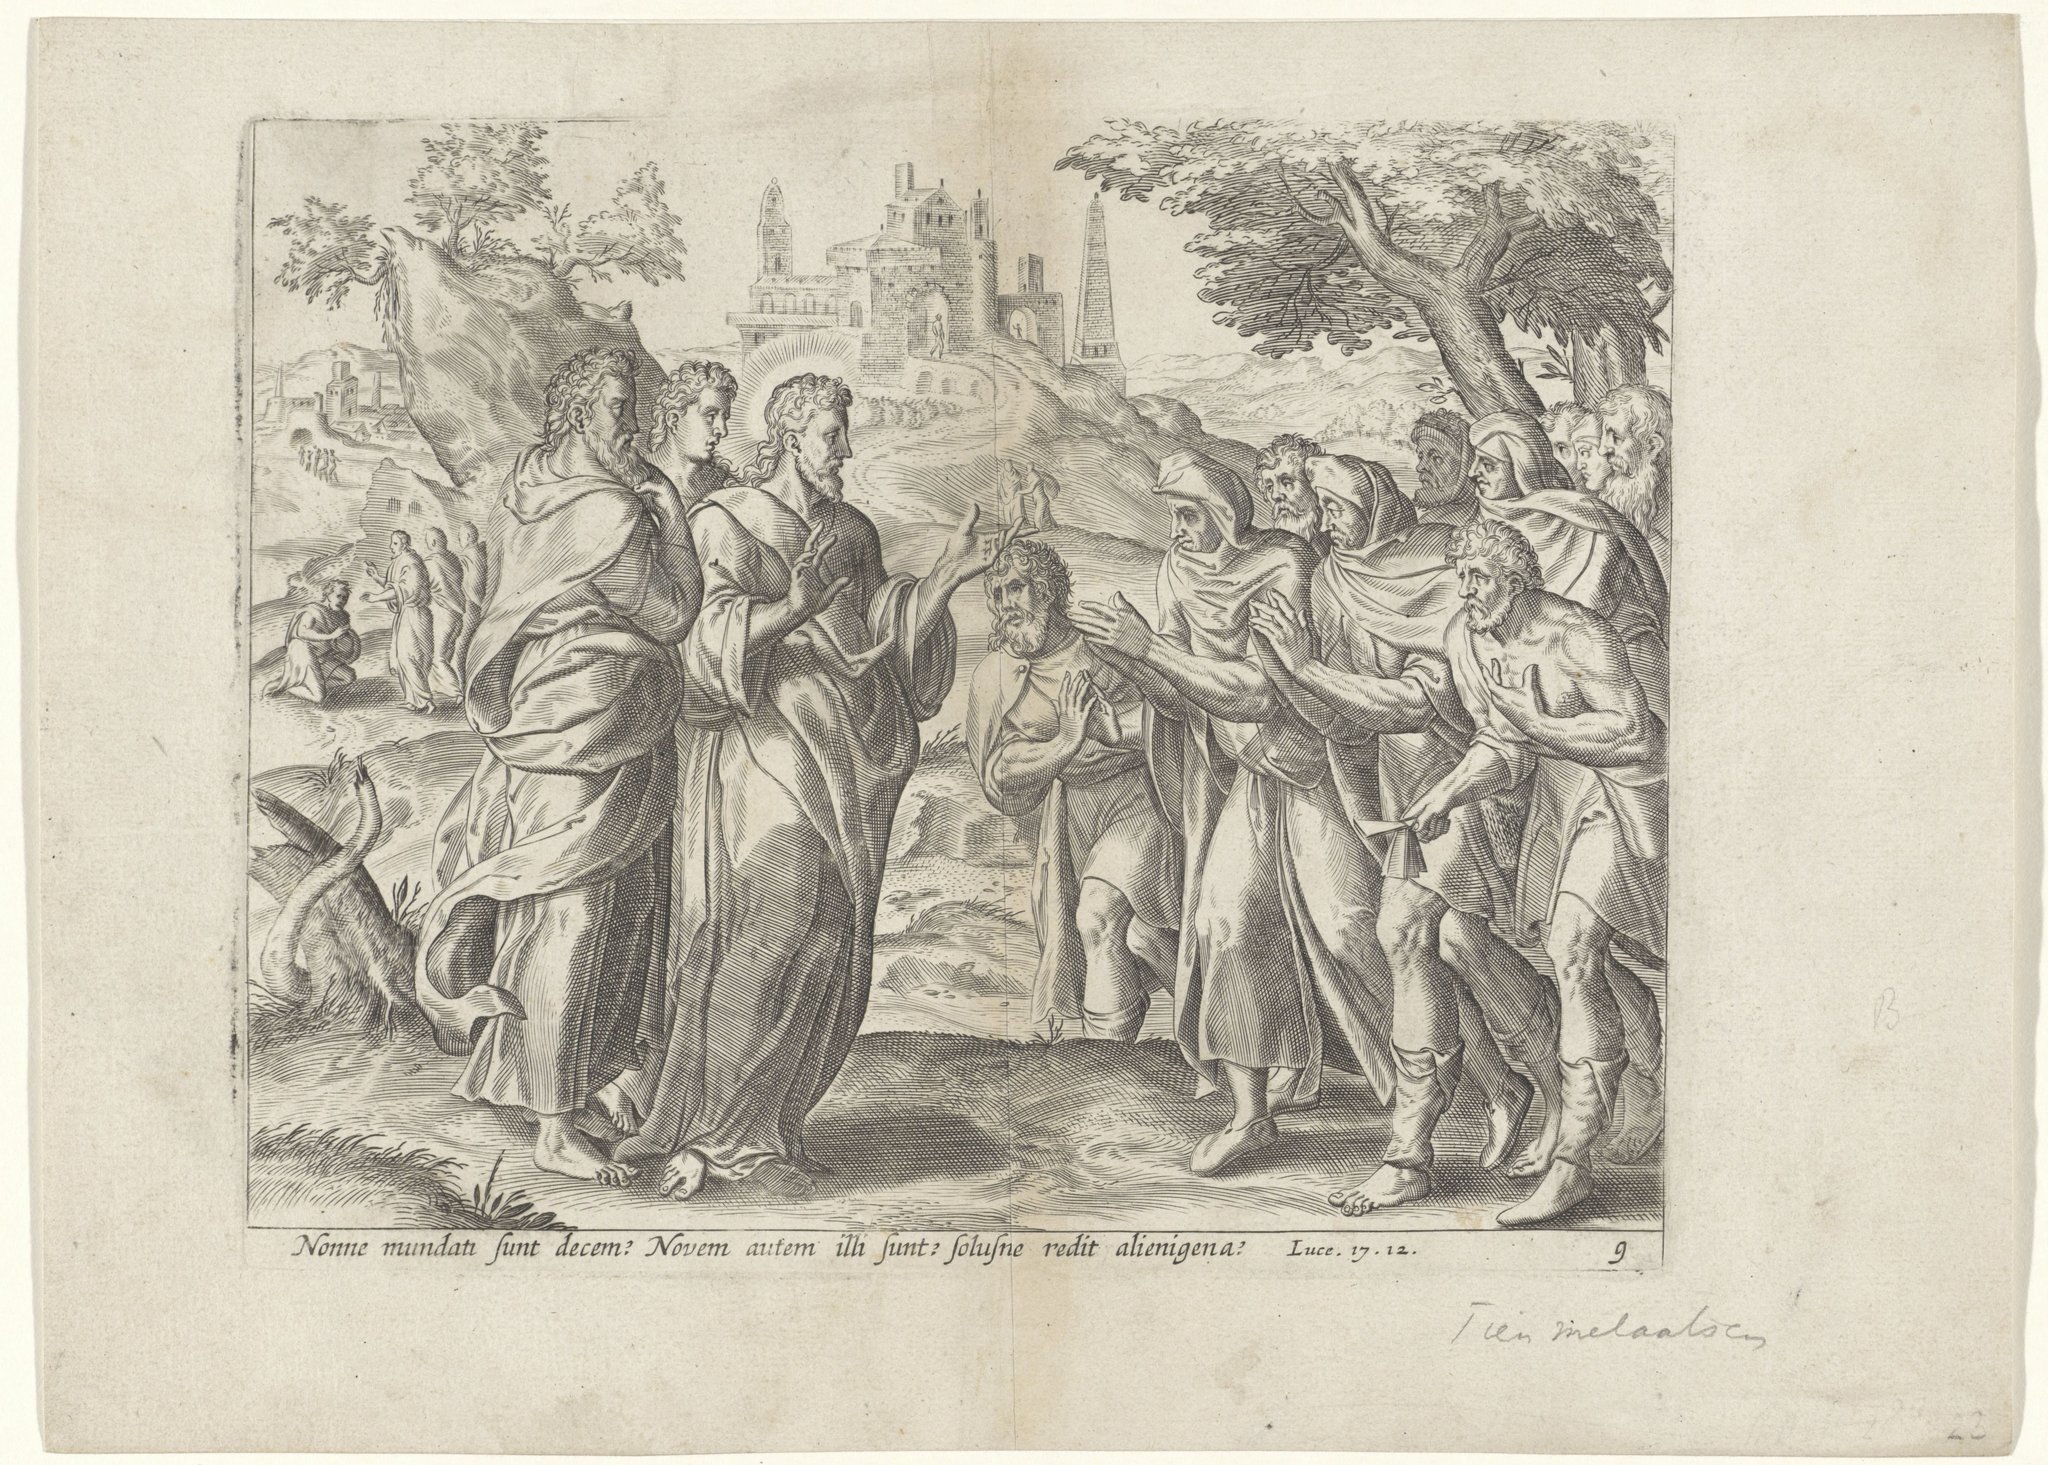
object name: print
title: Theatrum biblicum (...)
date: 1585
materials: paper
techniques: engraving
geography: antwerp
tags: one leper, a samaritan, sent to the priest by christ, returns and kneels before him, christ sends ten lepers to the priest (luke 17:11-19)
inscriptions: collector's mark: Lugt 2228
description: Christus trekt door het grensgebied van Samaria en Galilea. In een dorp ontmoet hij tien melaatsen die hij geneest. Links op de achtergrond is te zien hoe slechts één van hen, een Samaritaan, neerknielt aan Christus' voeten om hem te bedanken. Onder de voorstelling een verwijzing in het Latijn naar de Bijbeltekst in Luc. 17:12.